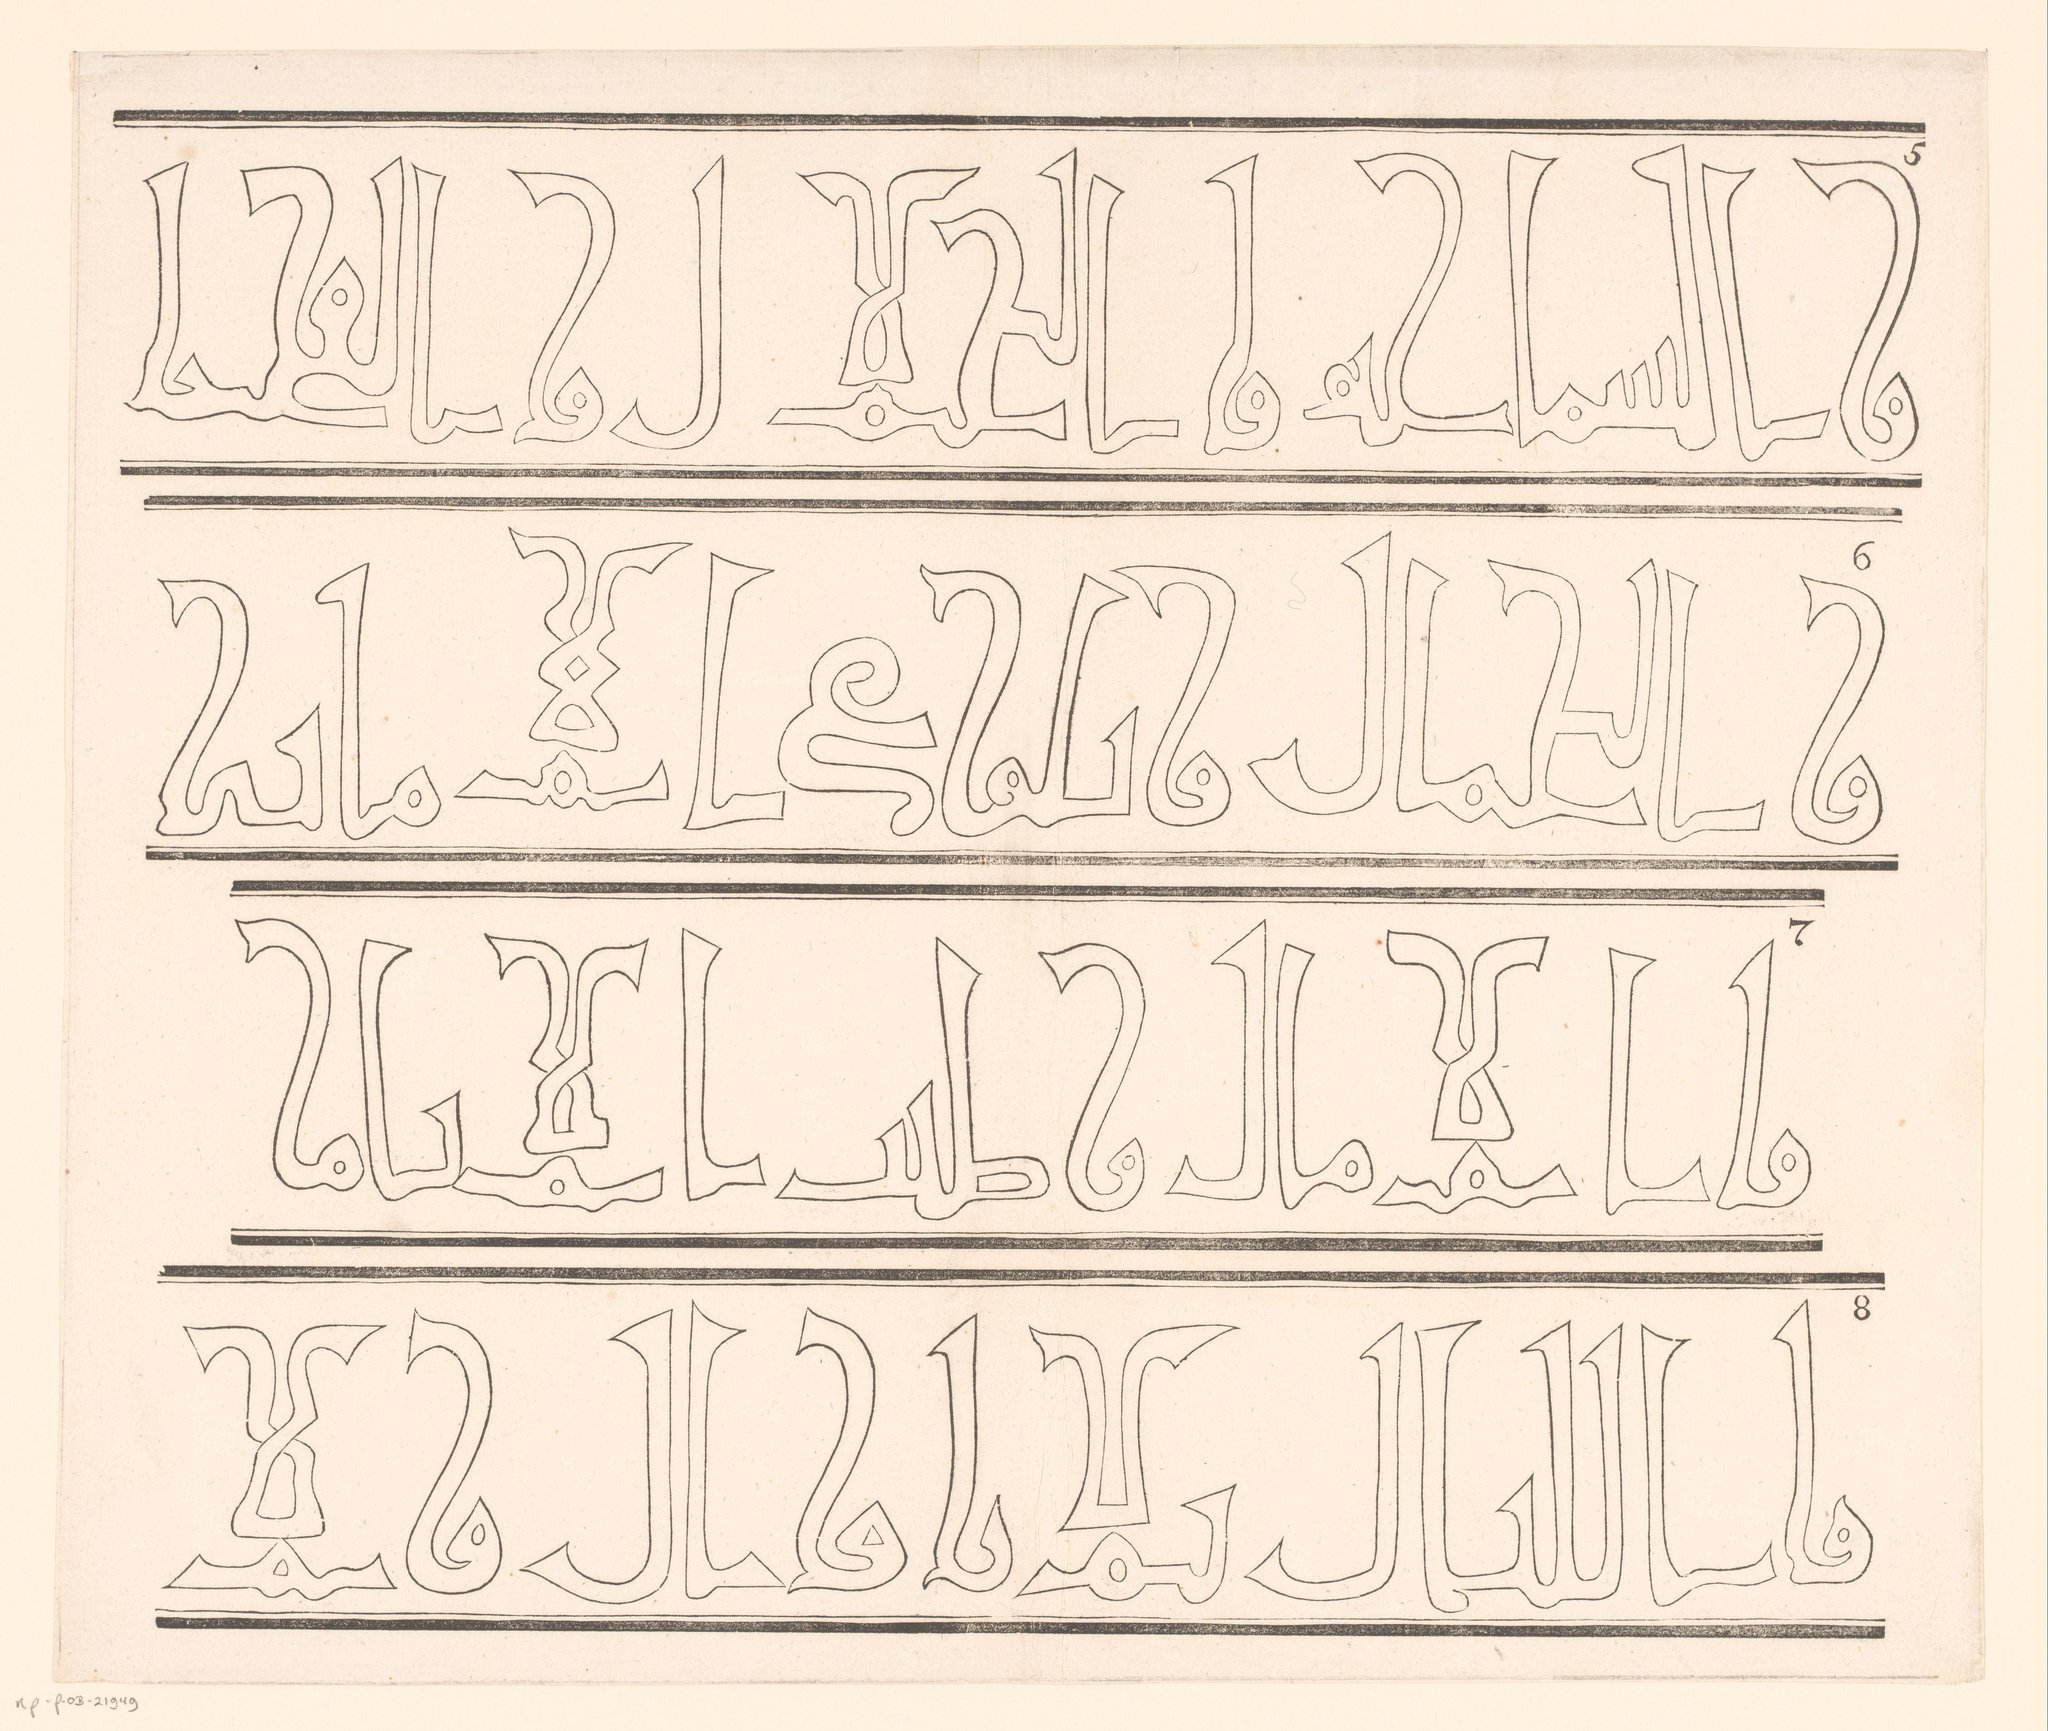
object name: print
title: Inscripties in Arabisch schrift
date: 1777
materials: paper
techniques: woodcut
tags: arabic script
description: Vier bladen met kopieën gemaakt naar inscripties in Arabisch schrift, ontdekt in een kerk op 13 mei 1774.